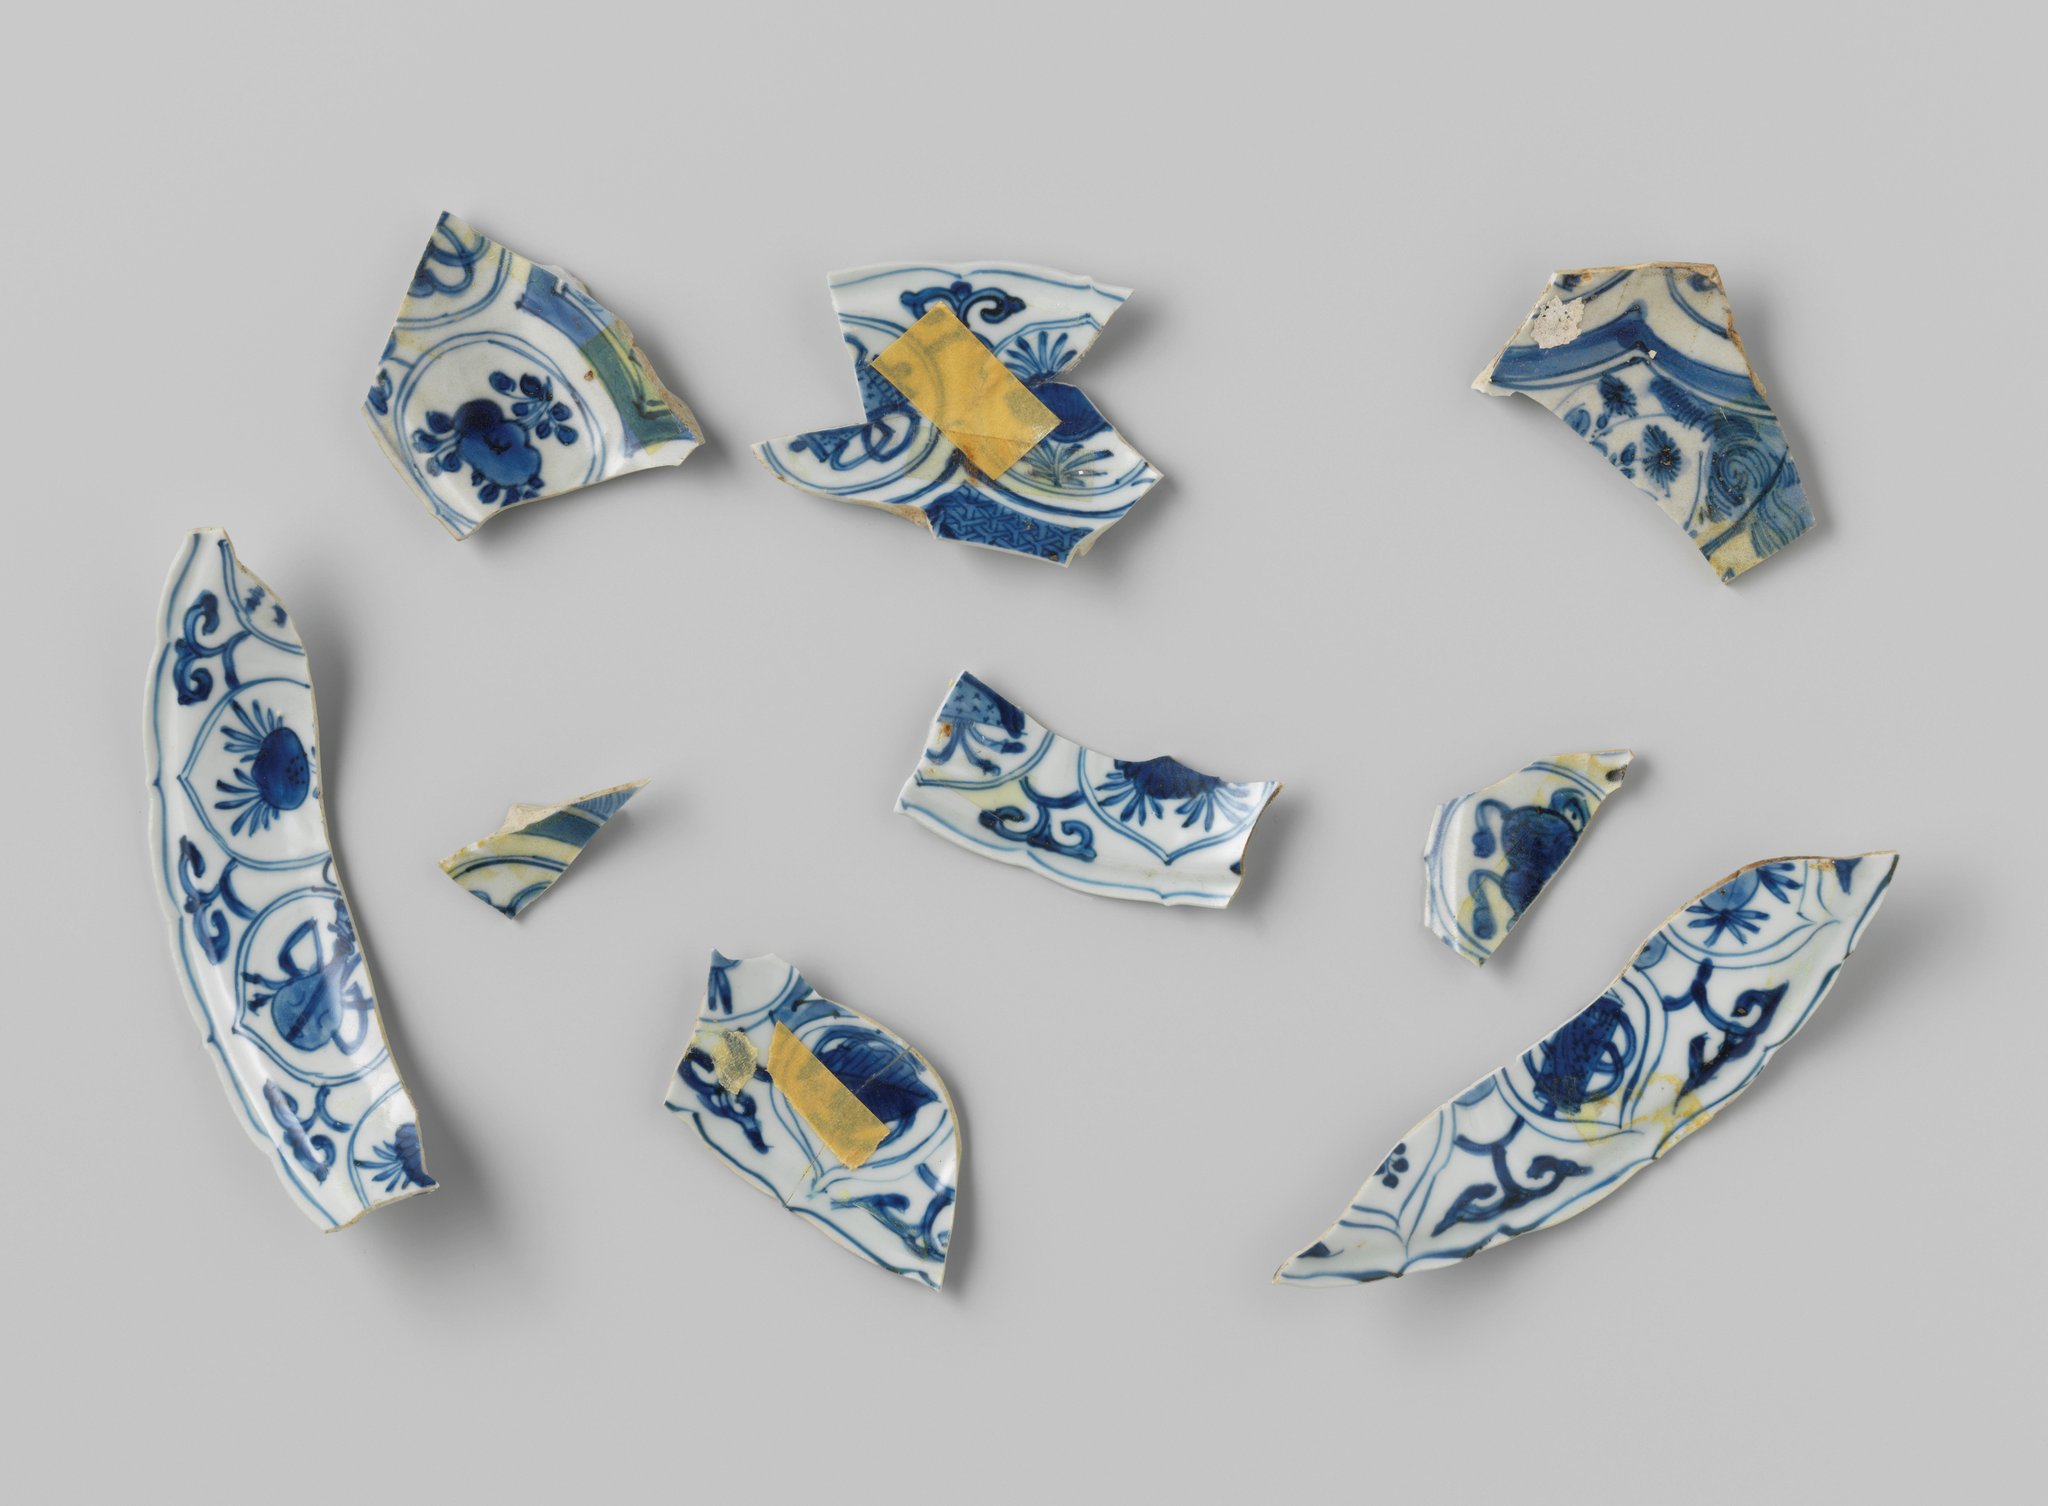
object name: plate dish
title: Scherven van kraakporseleinen borden uit V.O.C.-schip de 'Witte Leeuw'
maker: Anonymous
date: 1613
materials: bone china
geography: jingdezhen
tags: verenigde oostindische compagnie, sint-helena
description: Scherven van kraakporseleinen borden uit V.O.C.-schip de 'Witte Leeuw'.